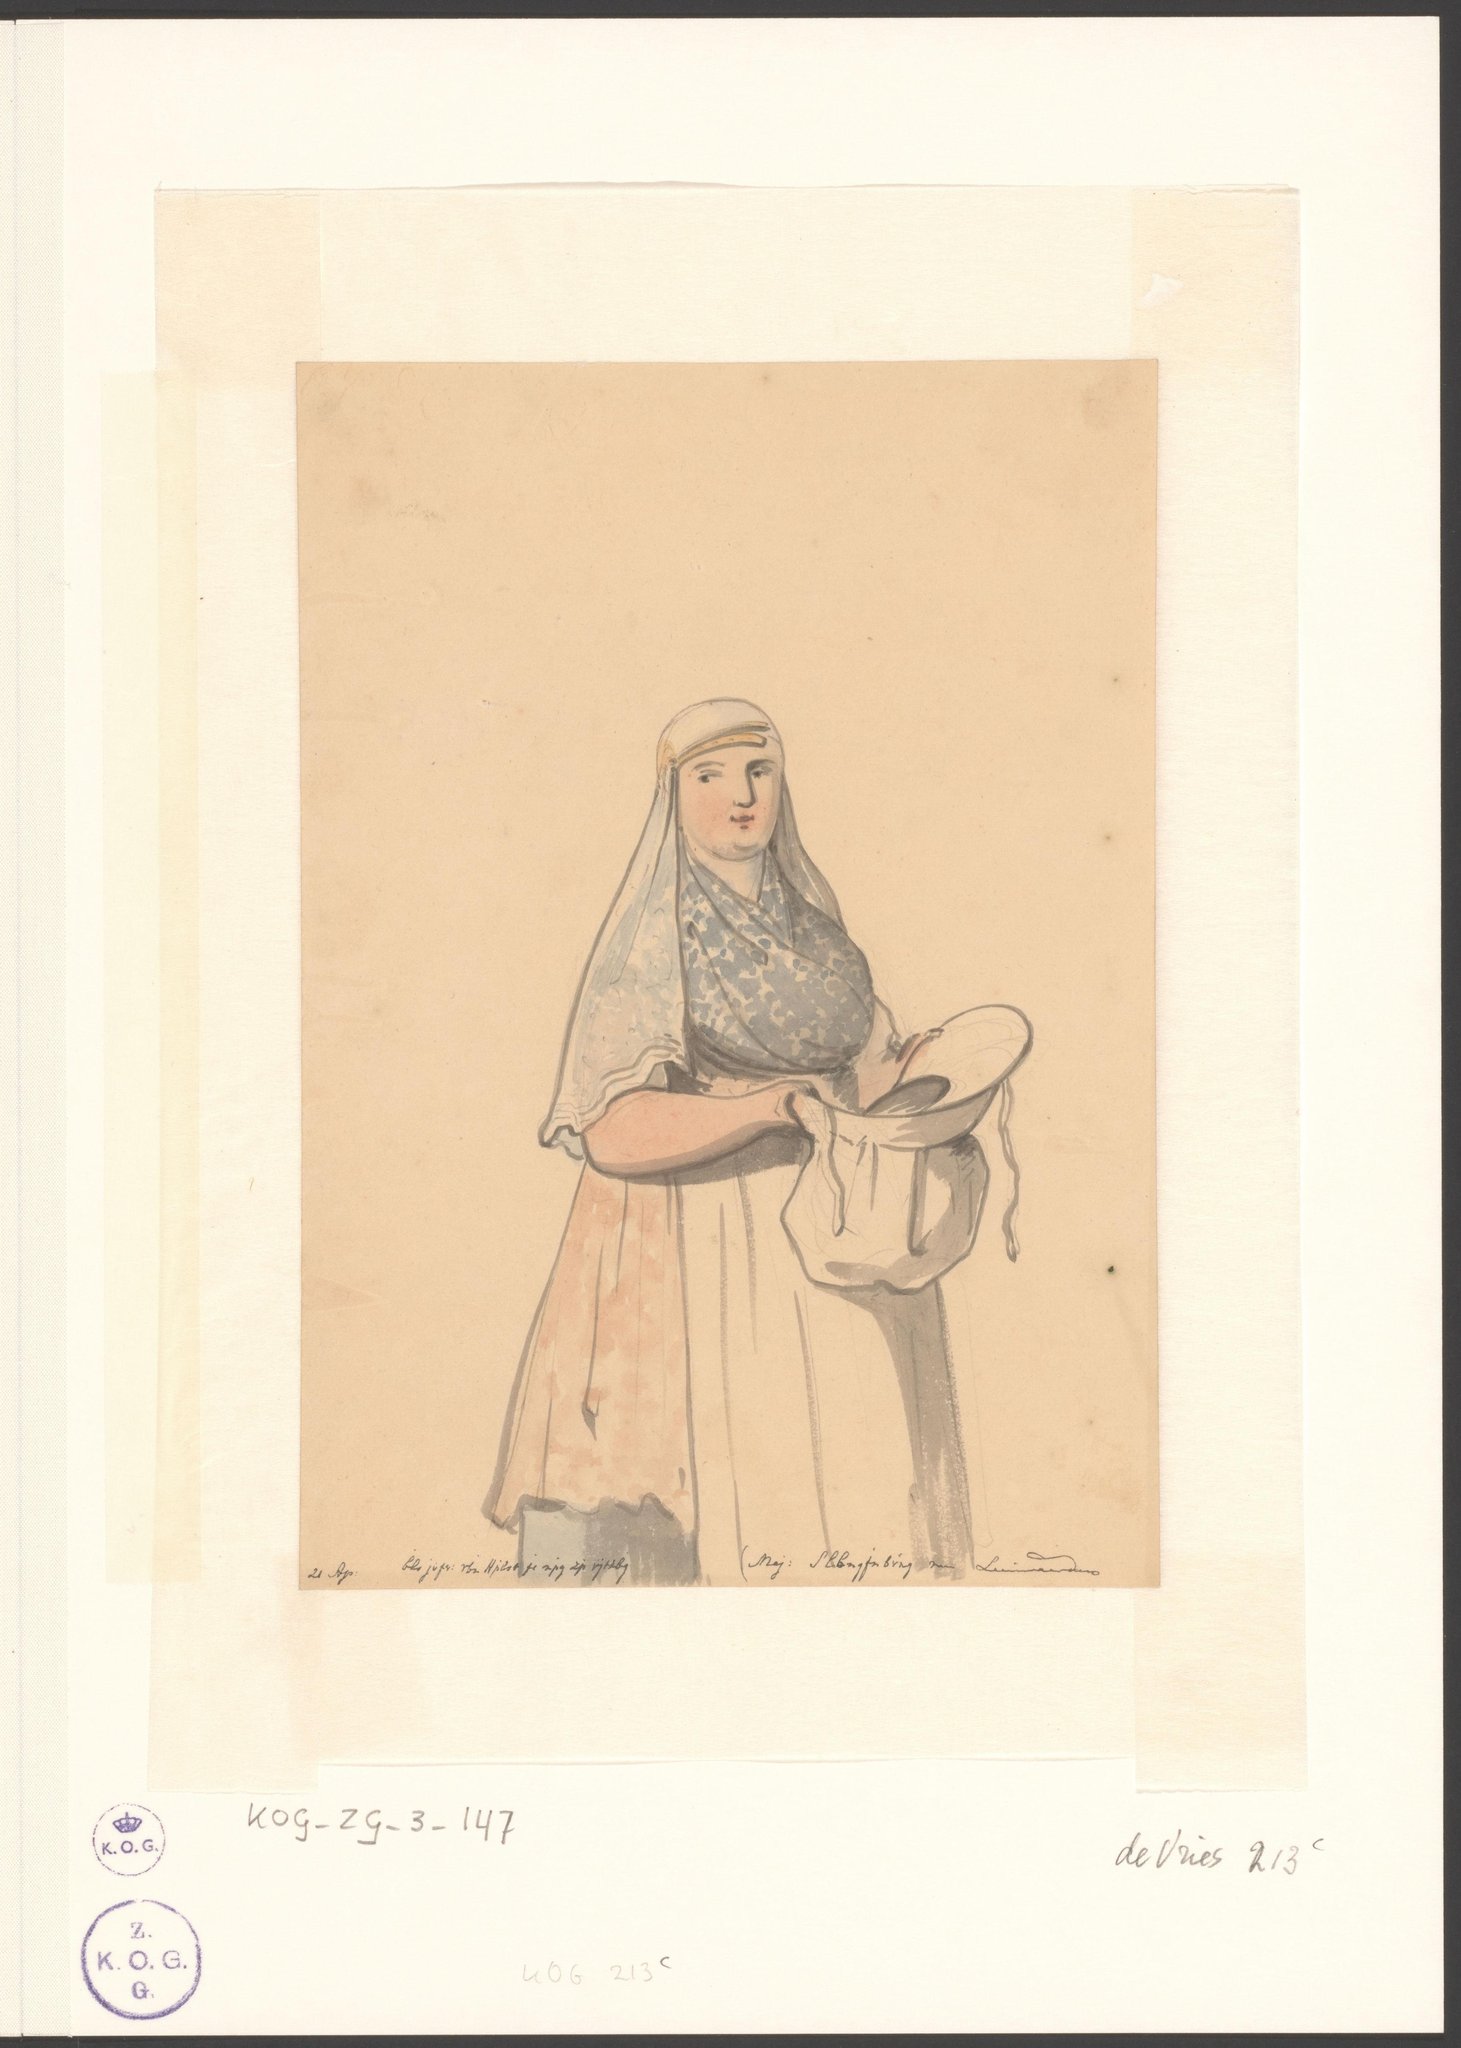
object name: drawing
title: Portret van de zuster van de Friese schilder C.J. van Baar van Slangenburgh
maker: christiaan andriessen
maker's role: draughtsman, print maker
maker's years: 1775-1846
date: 1806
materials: ink, paper, pencil, watercolor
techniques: brush, pen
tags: historical persons not known by name - bb - woman, folk costume, regional costume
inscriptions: stamp: Lugt 1641a, inscription: ‘21 ap: als jufv. van Holst er nog zo uitzag (mej. Slangenburg van Leeuwarden’, signature: ‘J Andriessen’, stamp: Lugt 1641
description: In het commentaar van Andriessen staat dat hij had gewild dat zijn beoogde verloofde er zo uitzag. Op verso een tweede portret van haar.